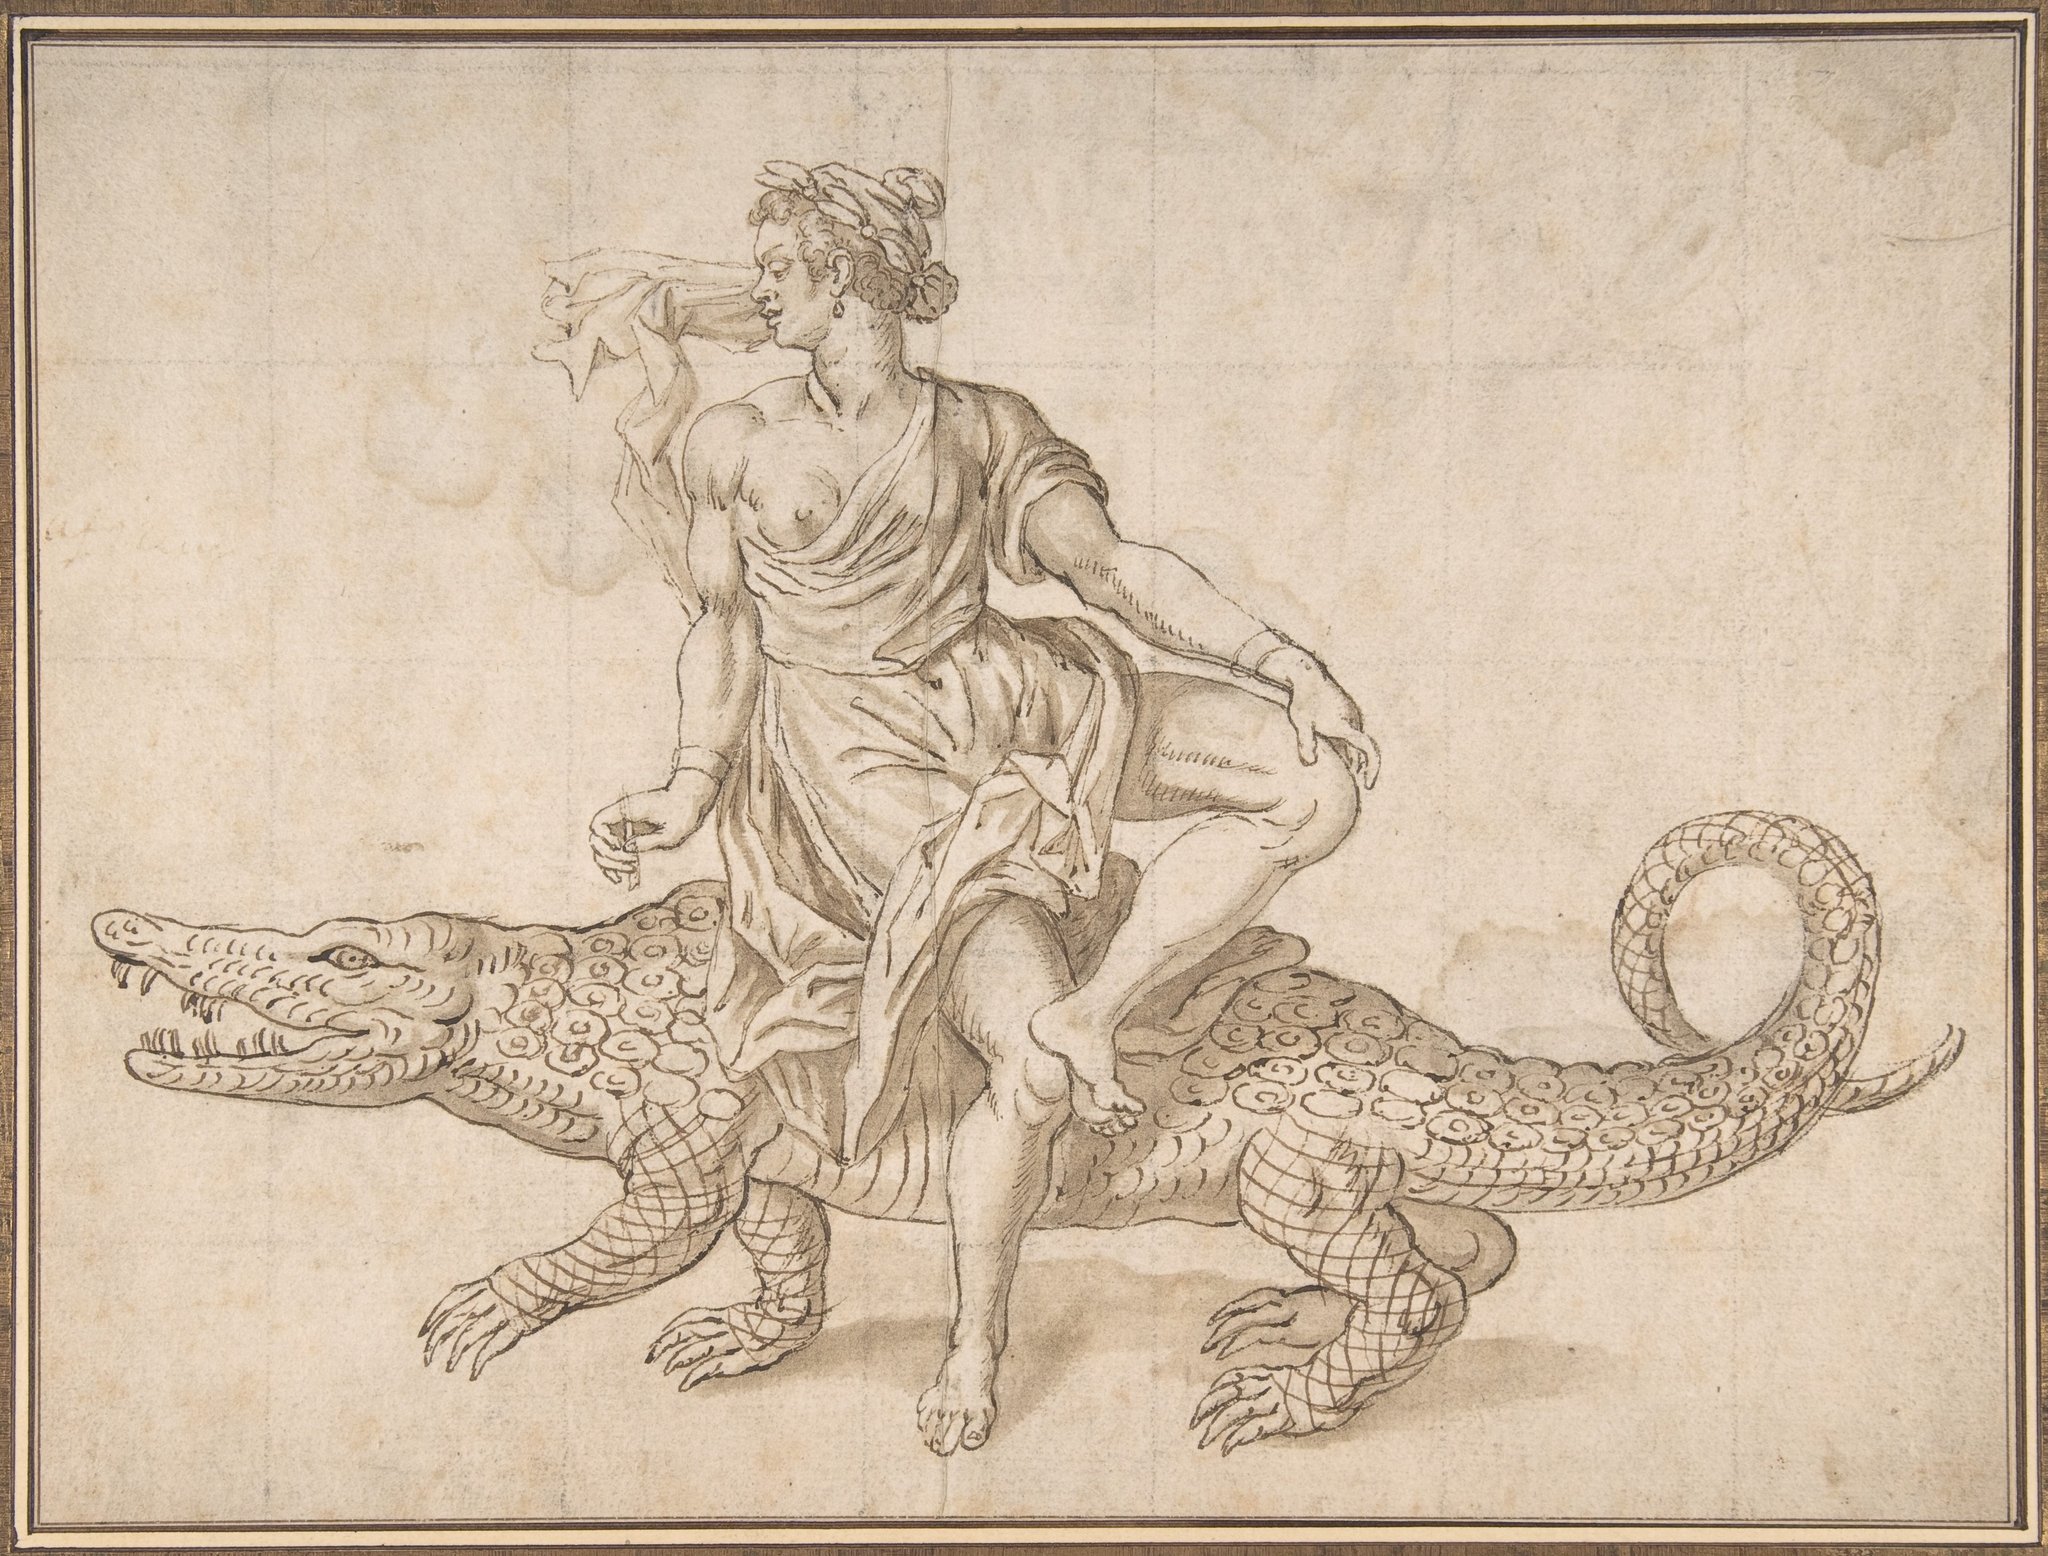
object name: drawing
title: Allegory of Africa, from "The Four Continents"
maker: anonymous, netherlandish, 16th century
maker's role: artist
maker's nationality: netherlandish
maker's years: 1500-1600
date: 1501-1600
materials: chalk, ink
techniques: brush, pen, drawing, wash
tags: female nudes,crocodiles